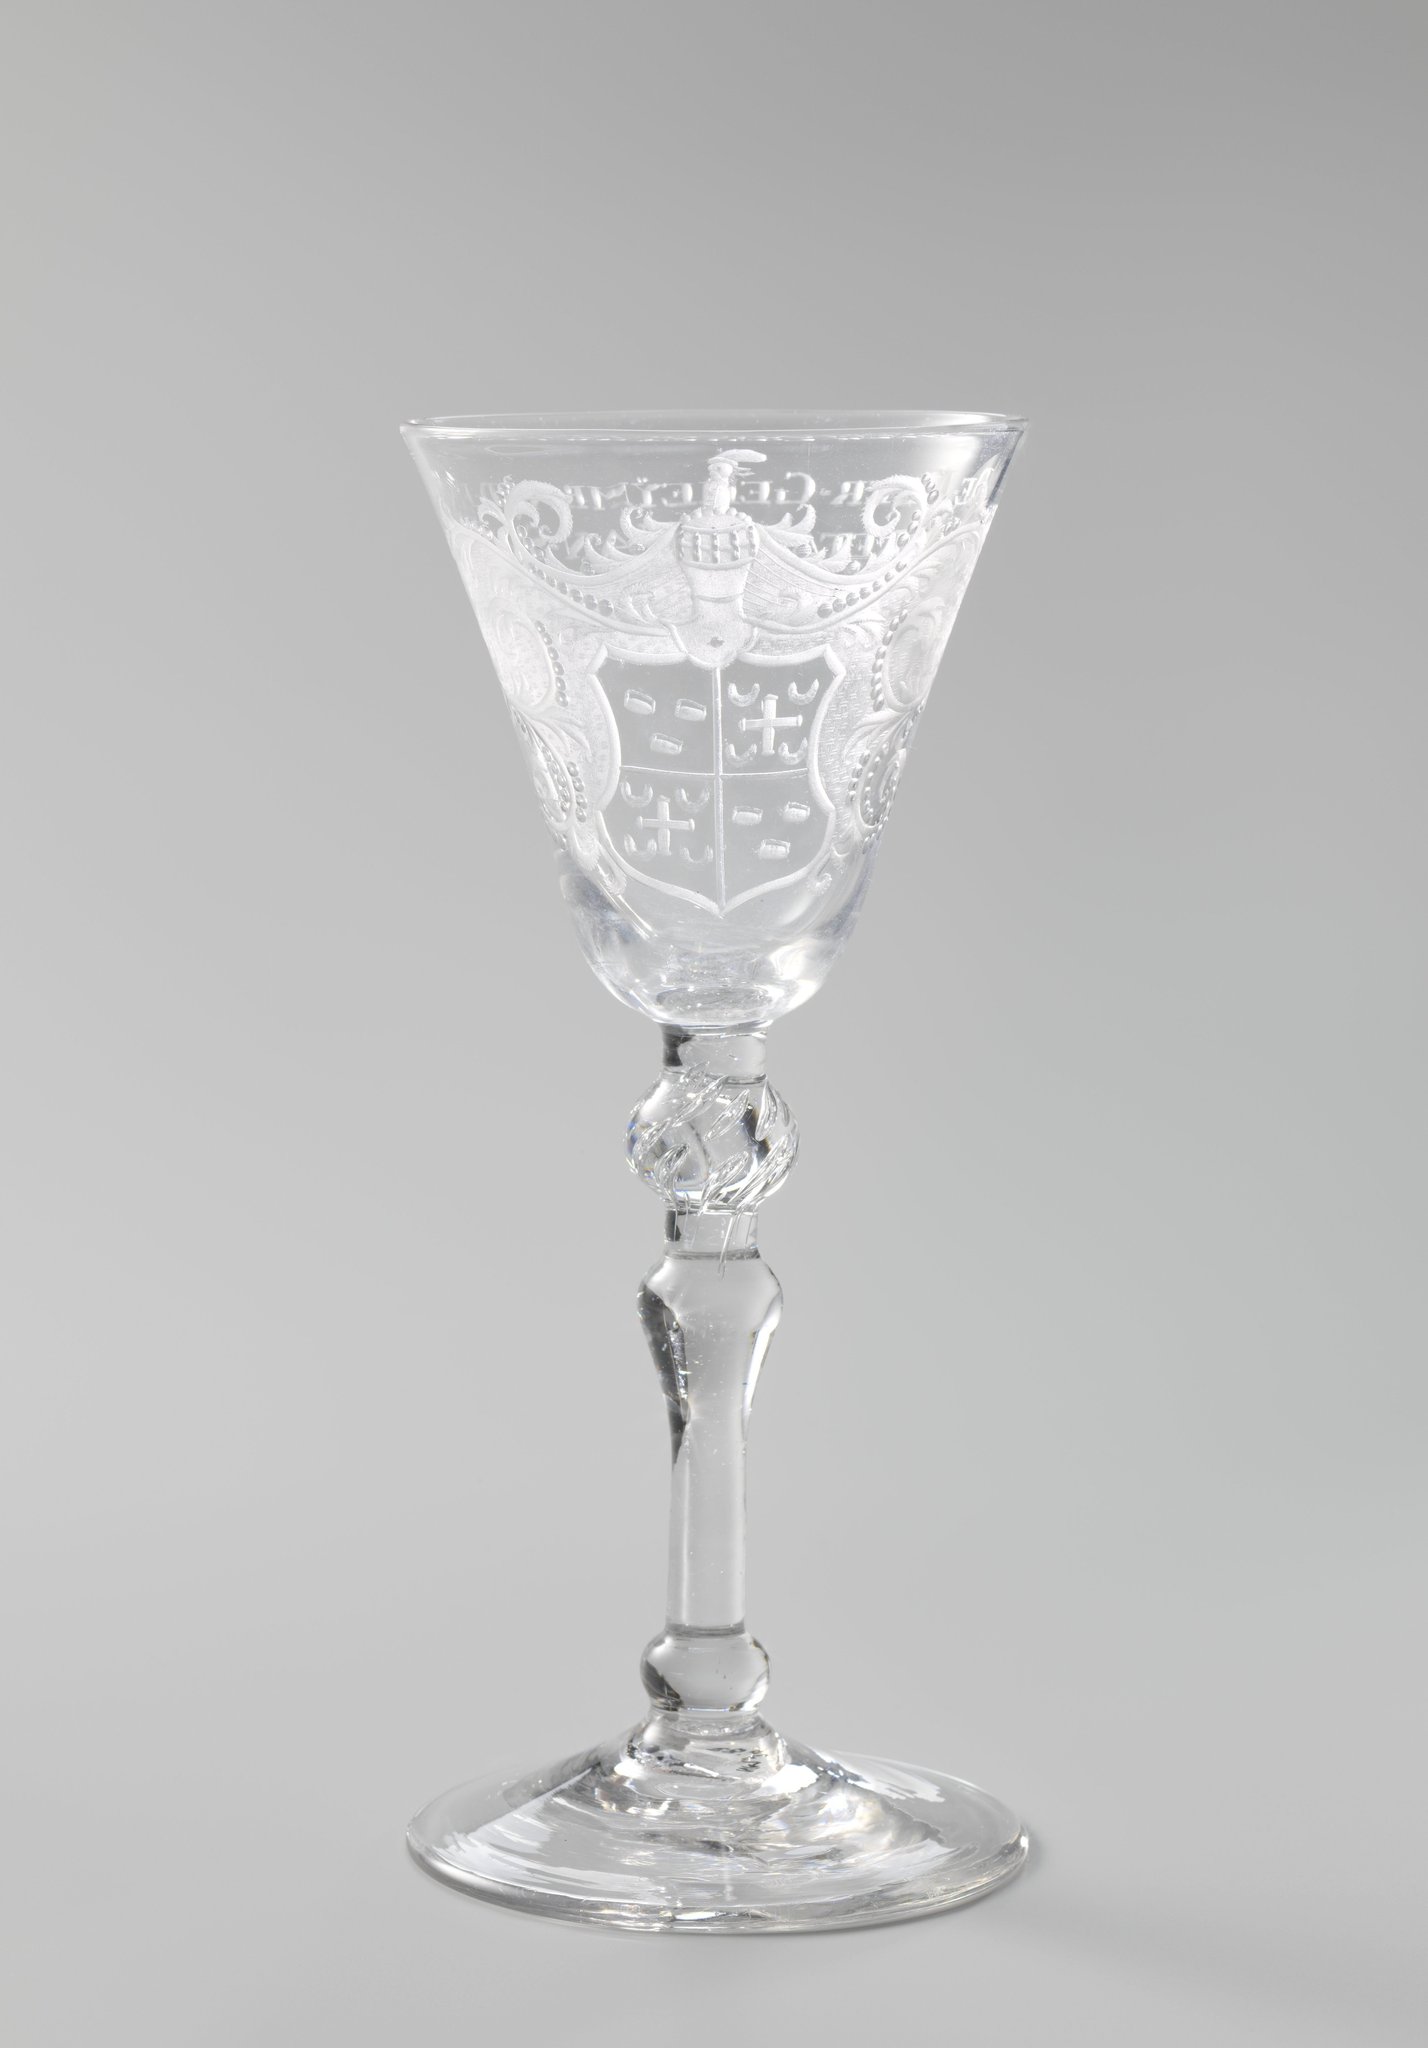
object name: goblet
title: Wine glass with the arms of Johan de Back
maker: Anonymous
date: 1750-1766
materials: glass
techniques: glassblowing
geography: northern netherlands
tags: rotterdam, the hague, willem iv (prins van oranje-nassau), armorial bearing, heraldry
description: translation of inscription: Privy Councillor and / Secretary to His / Highness, De Back